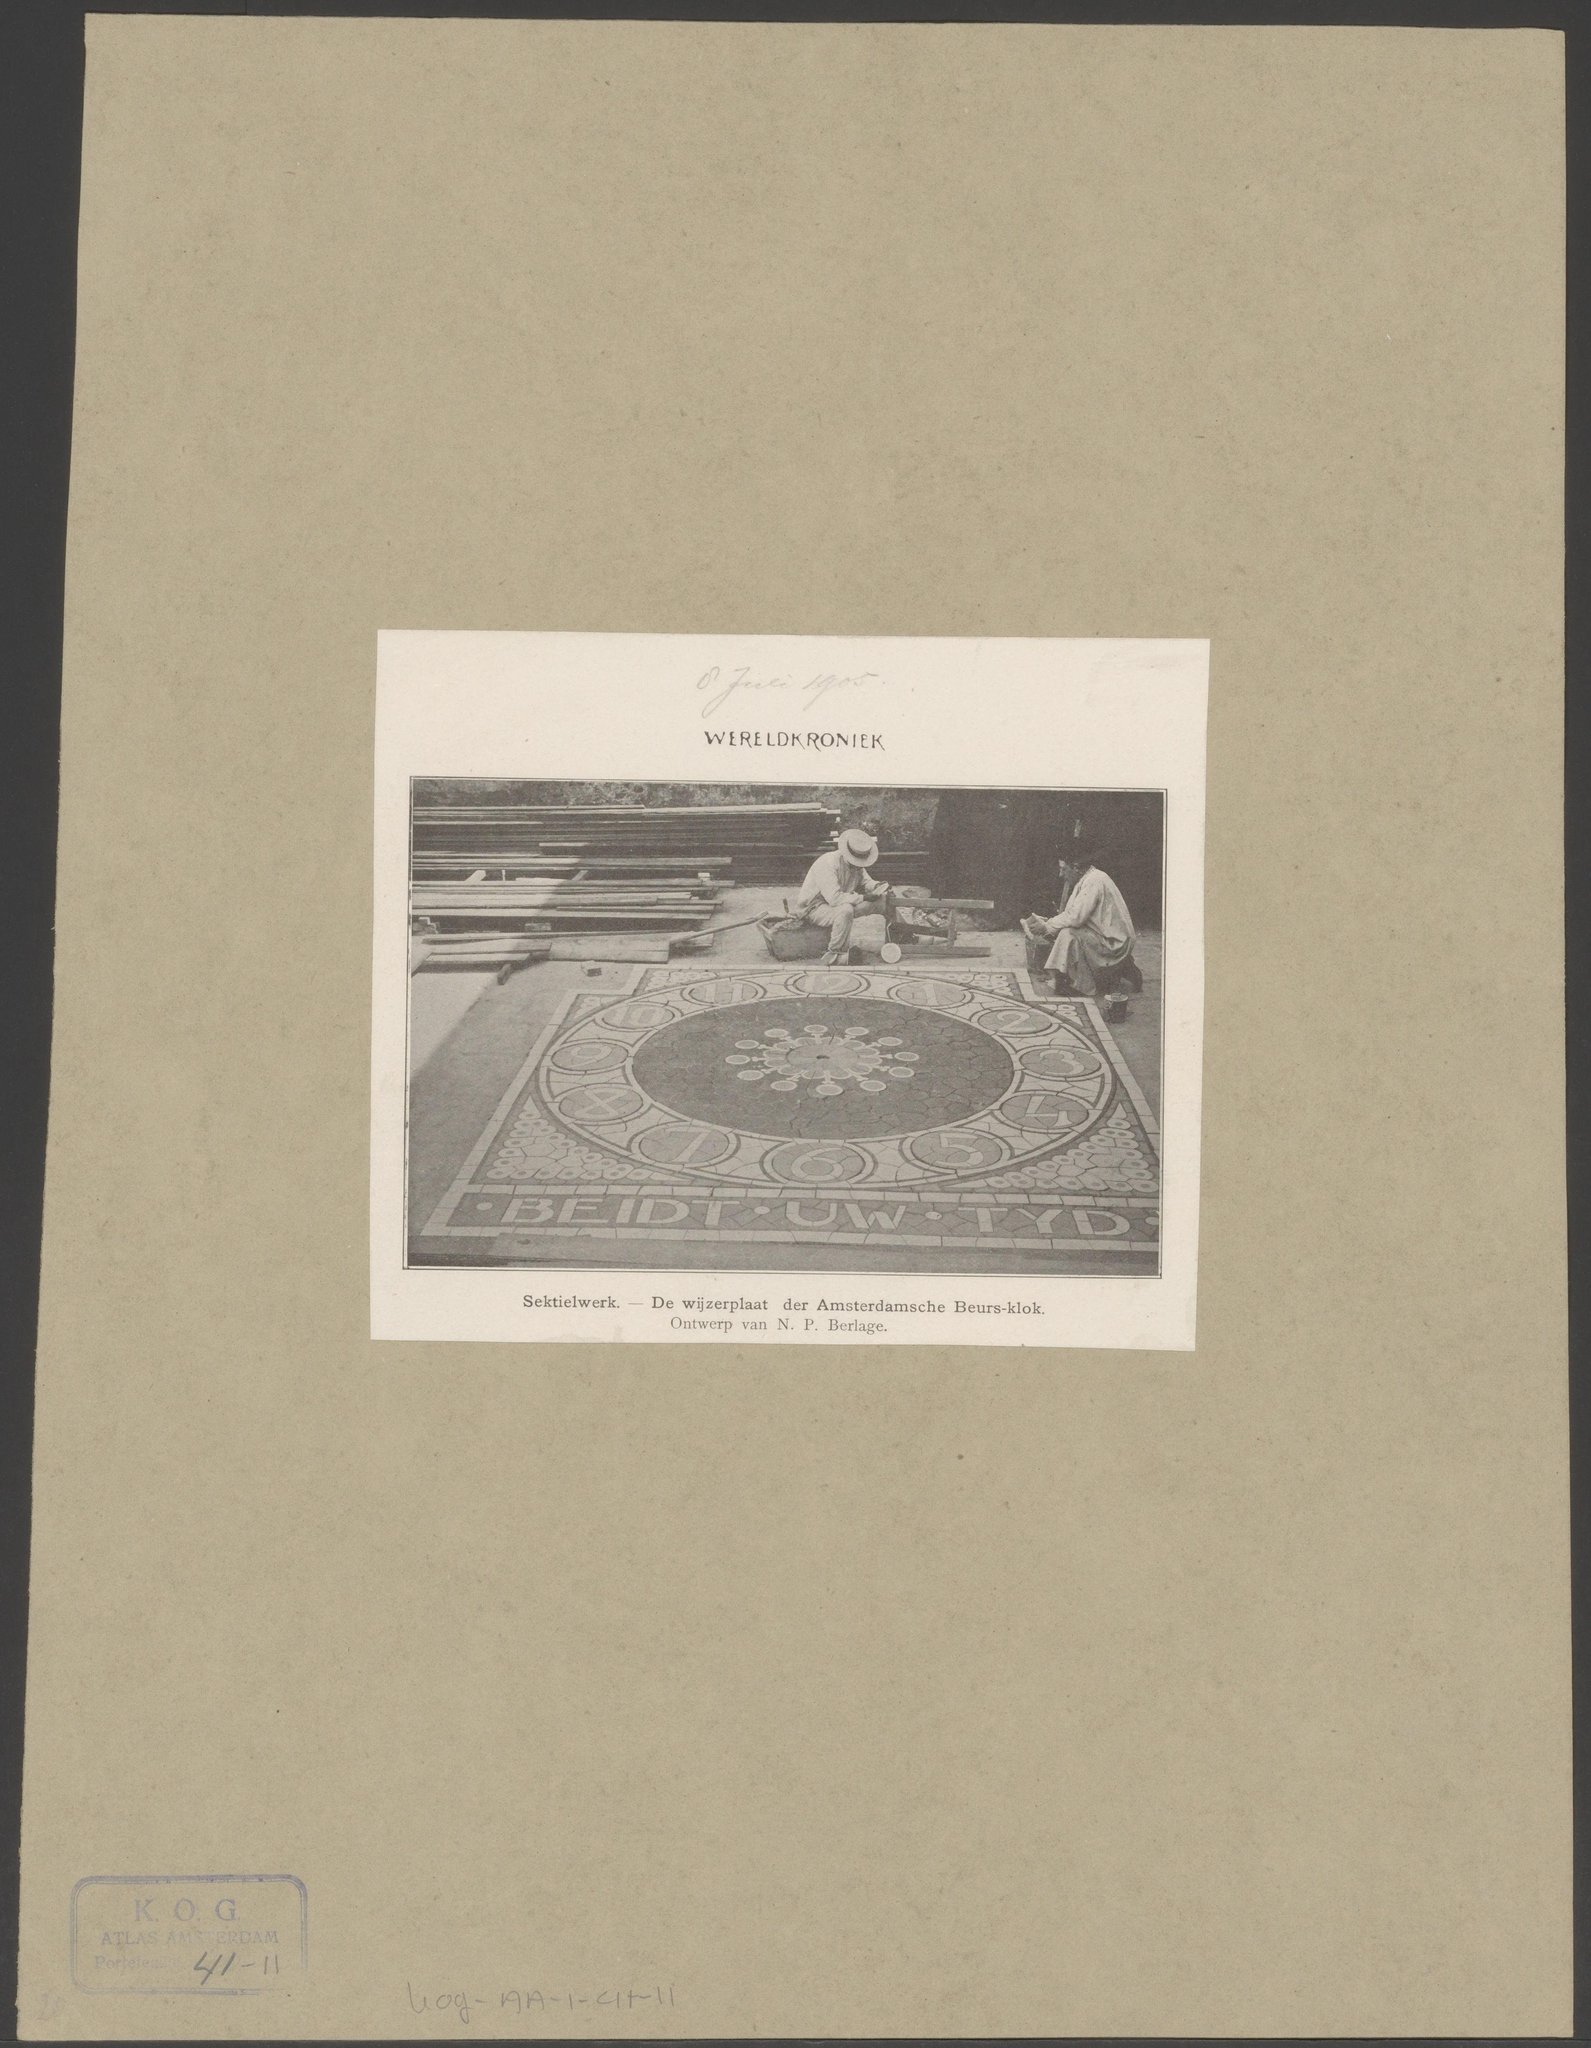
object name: photomechanical print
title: Twee vakmannen vervaardigen de wijzerplaat van de Beurs van Berlage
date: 1905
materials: paper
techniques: letterpress printing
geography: rotterdam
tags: stock exchange, stock-market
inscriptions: collector's mark: Lugt 1461b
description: Onderwerpsrubriek binnen de Atlas Amsterdam: B. Beurs op het Damrak.